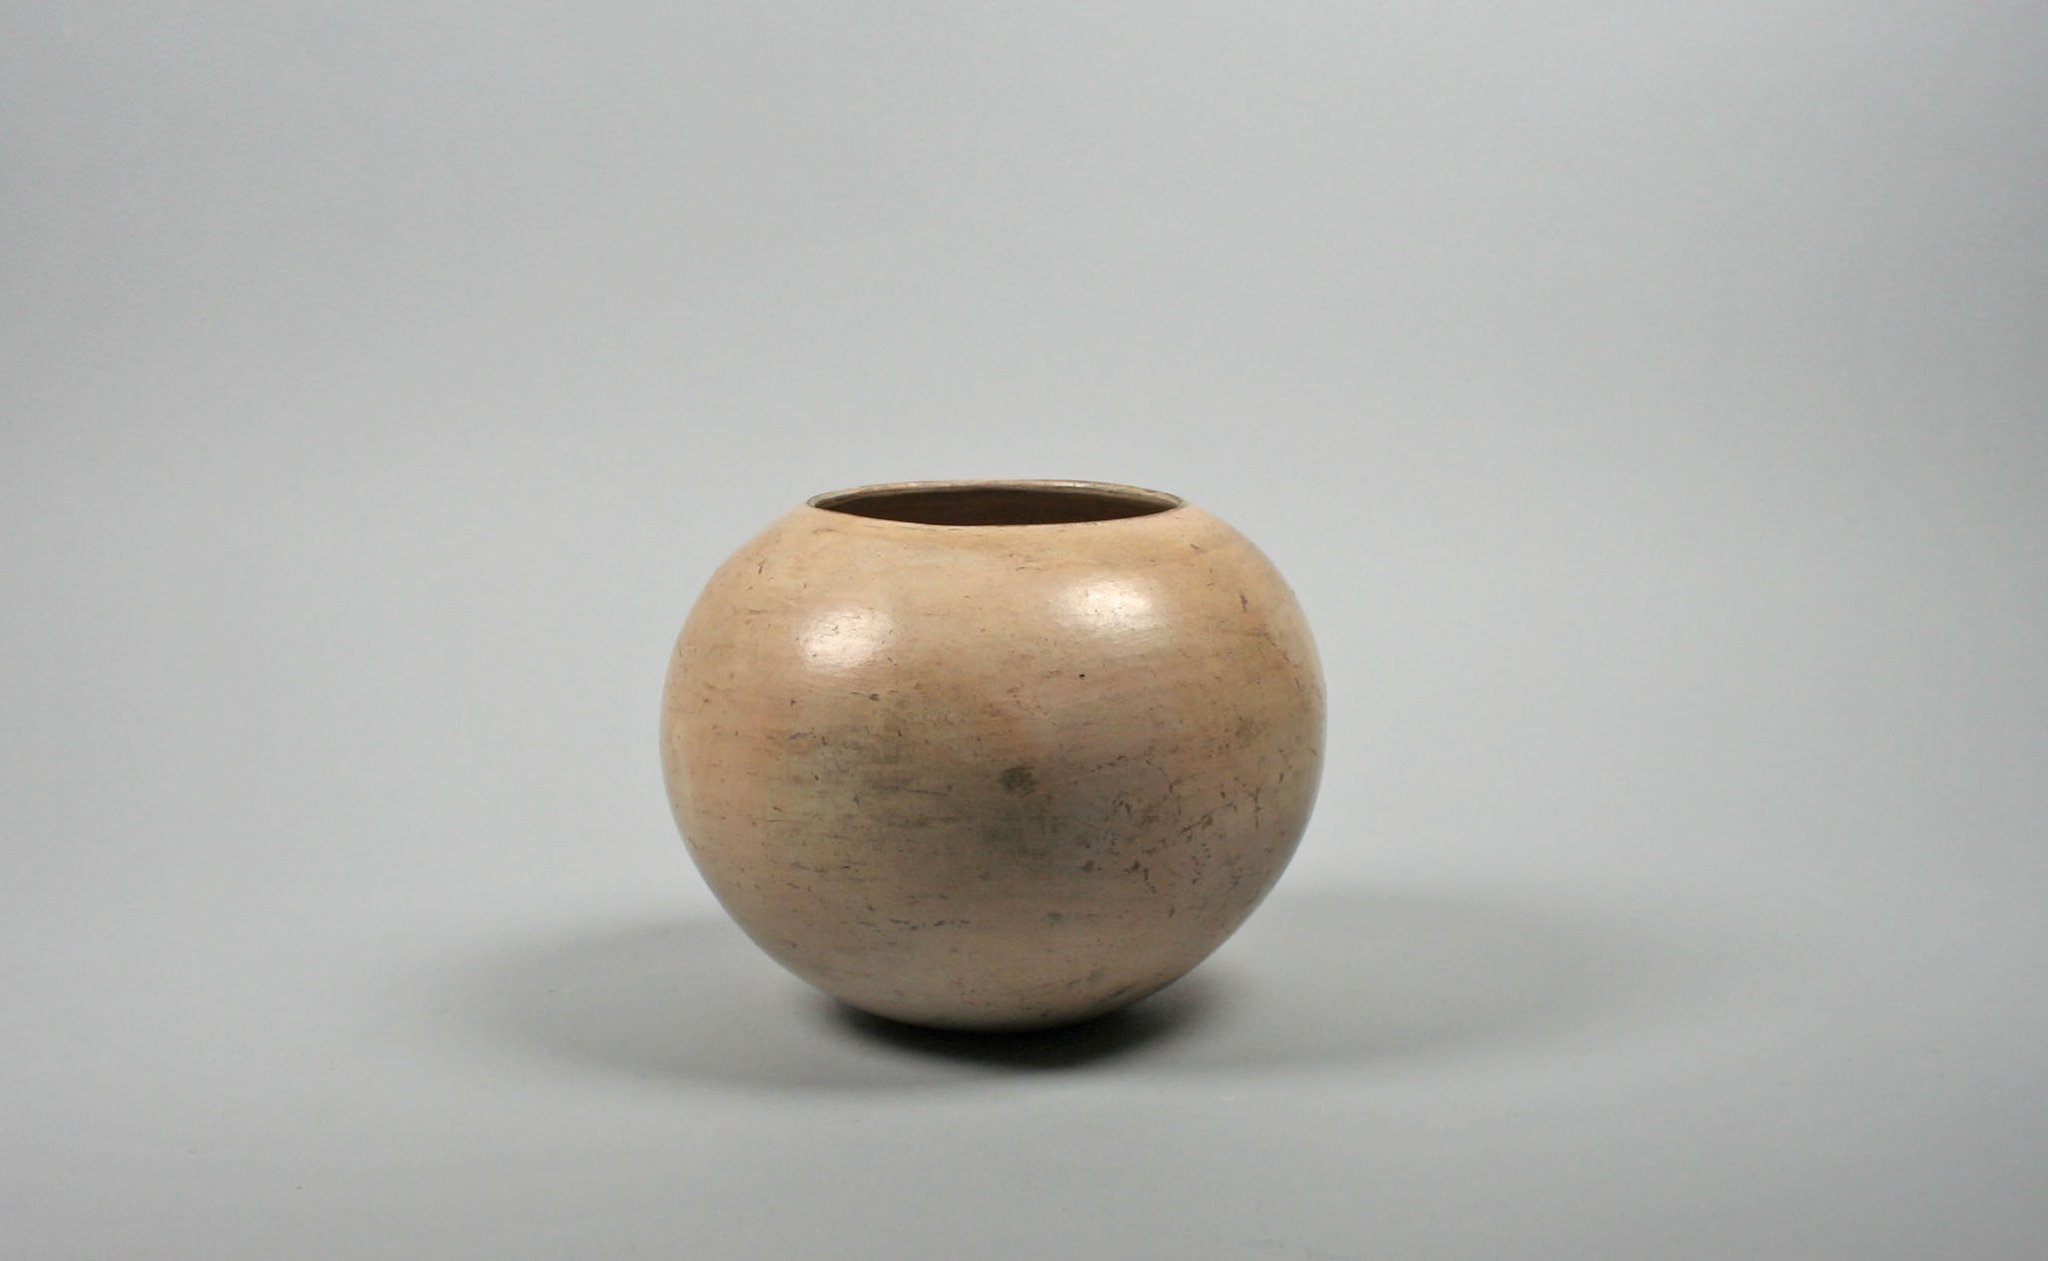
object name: bowl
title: Bowl (Tecomate)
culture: olmec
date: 1200-801 BCE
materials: ceramic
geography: mexico